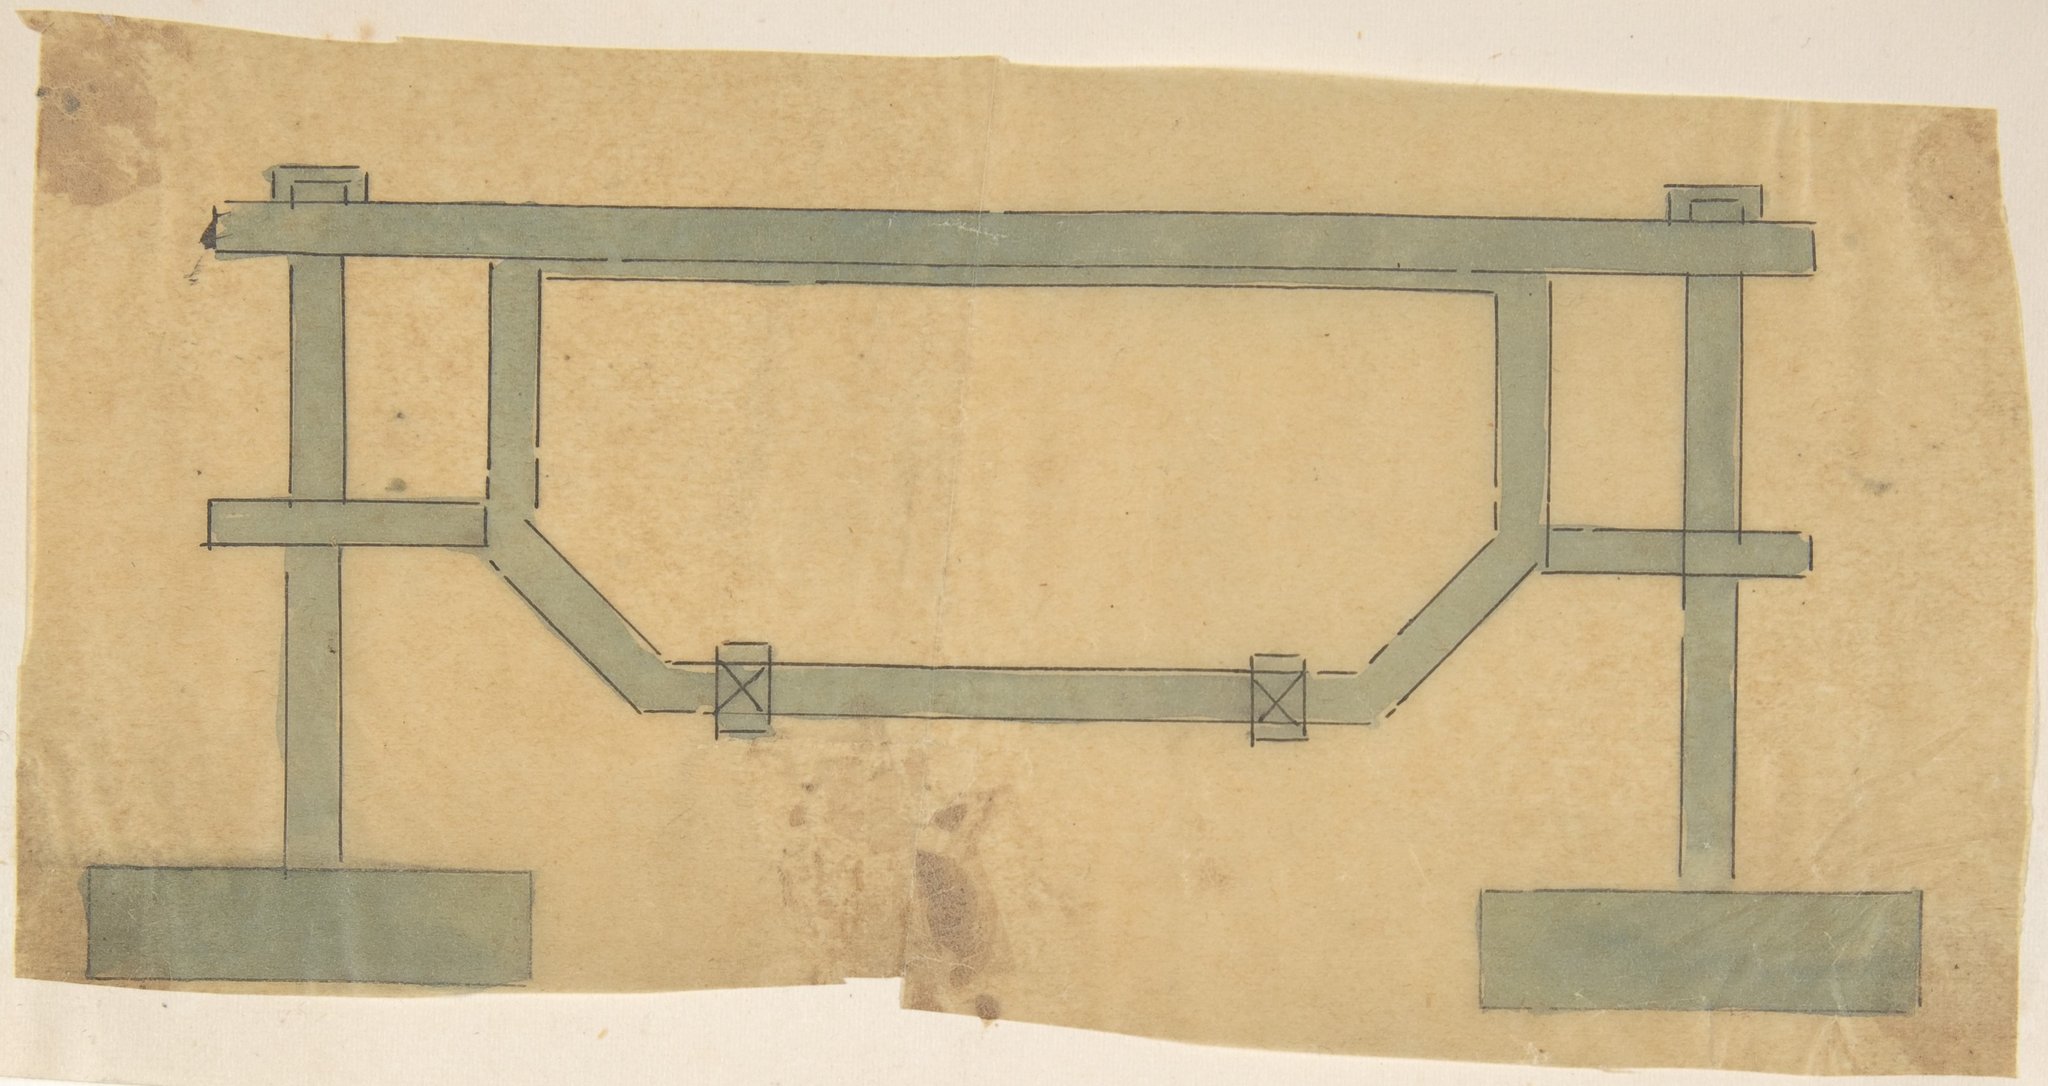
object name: drawing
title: Plan for a Grate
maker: anonymous, british, 19th century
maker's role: artist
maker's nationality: british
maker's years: 1800-1900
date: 1801-1900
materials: graphite, ink, watercolor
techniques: pen